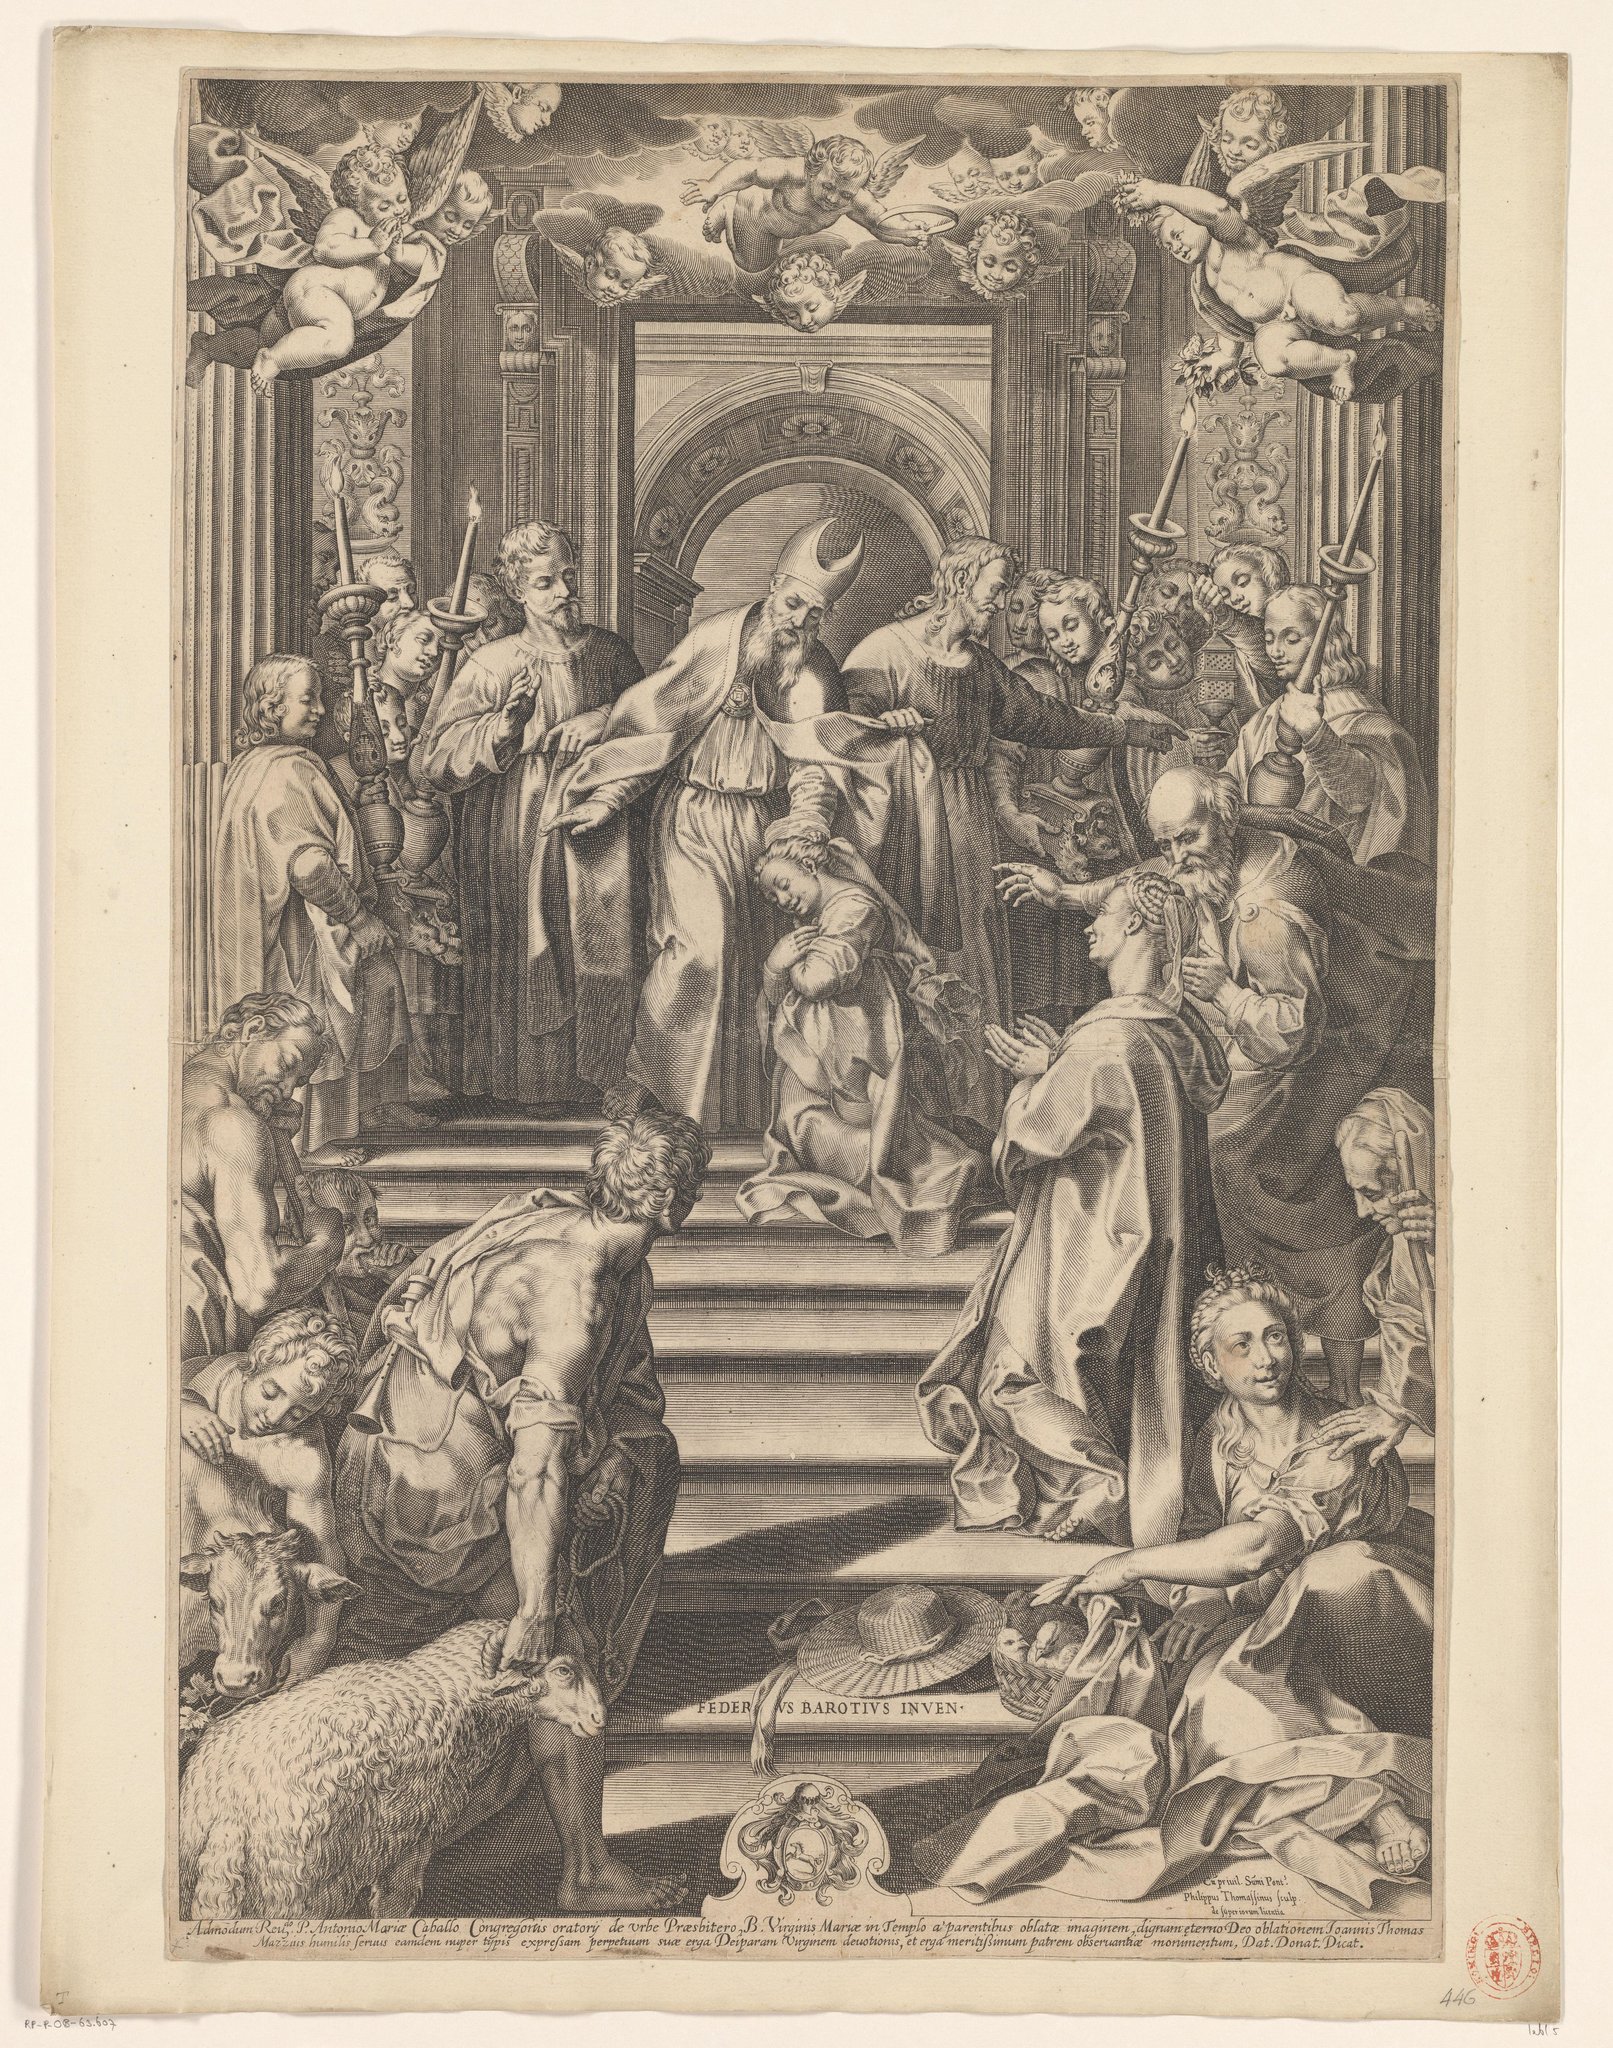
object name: print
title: Presentatie van Maria in de tempel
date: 1572-1622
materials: paper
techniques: engraving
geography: vatican city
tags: presentation of the christ-child in the temple, usually simeon (and anna) present (luke 2:22-39)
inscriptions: collector's mark: Lugt 240